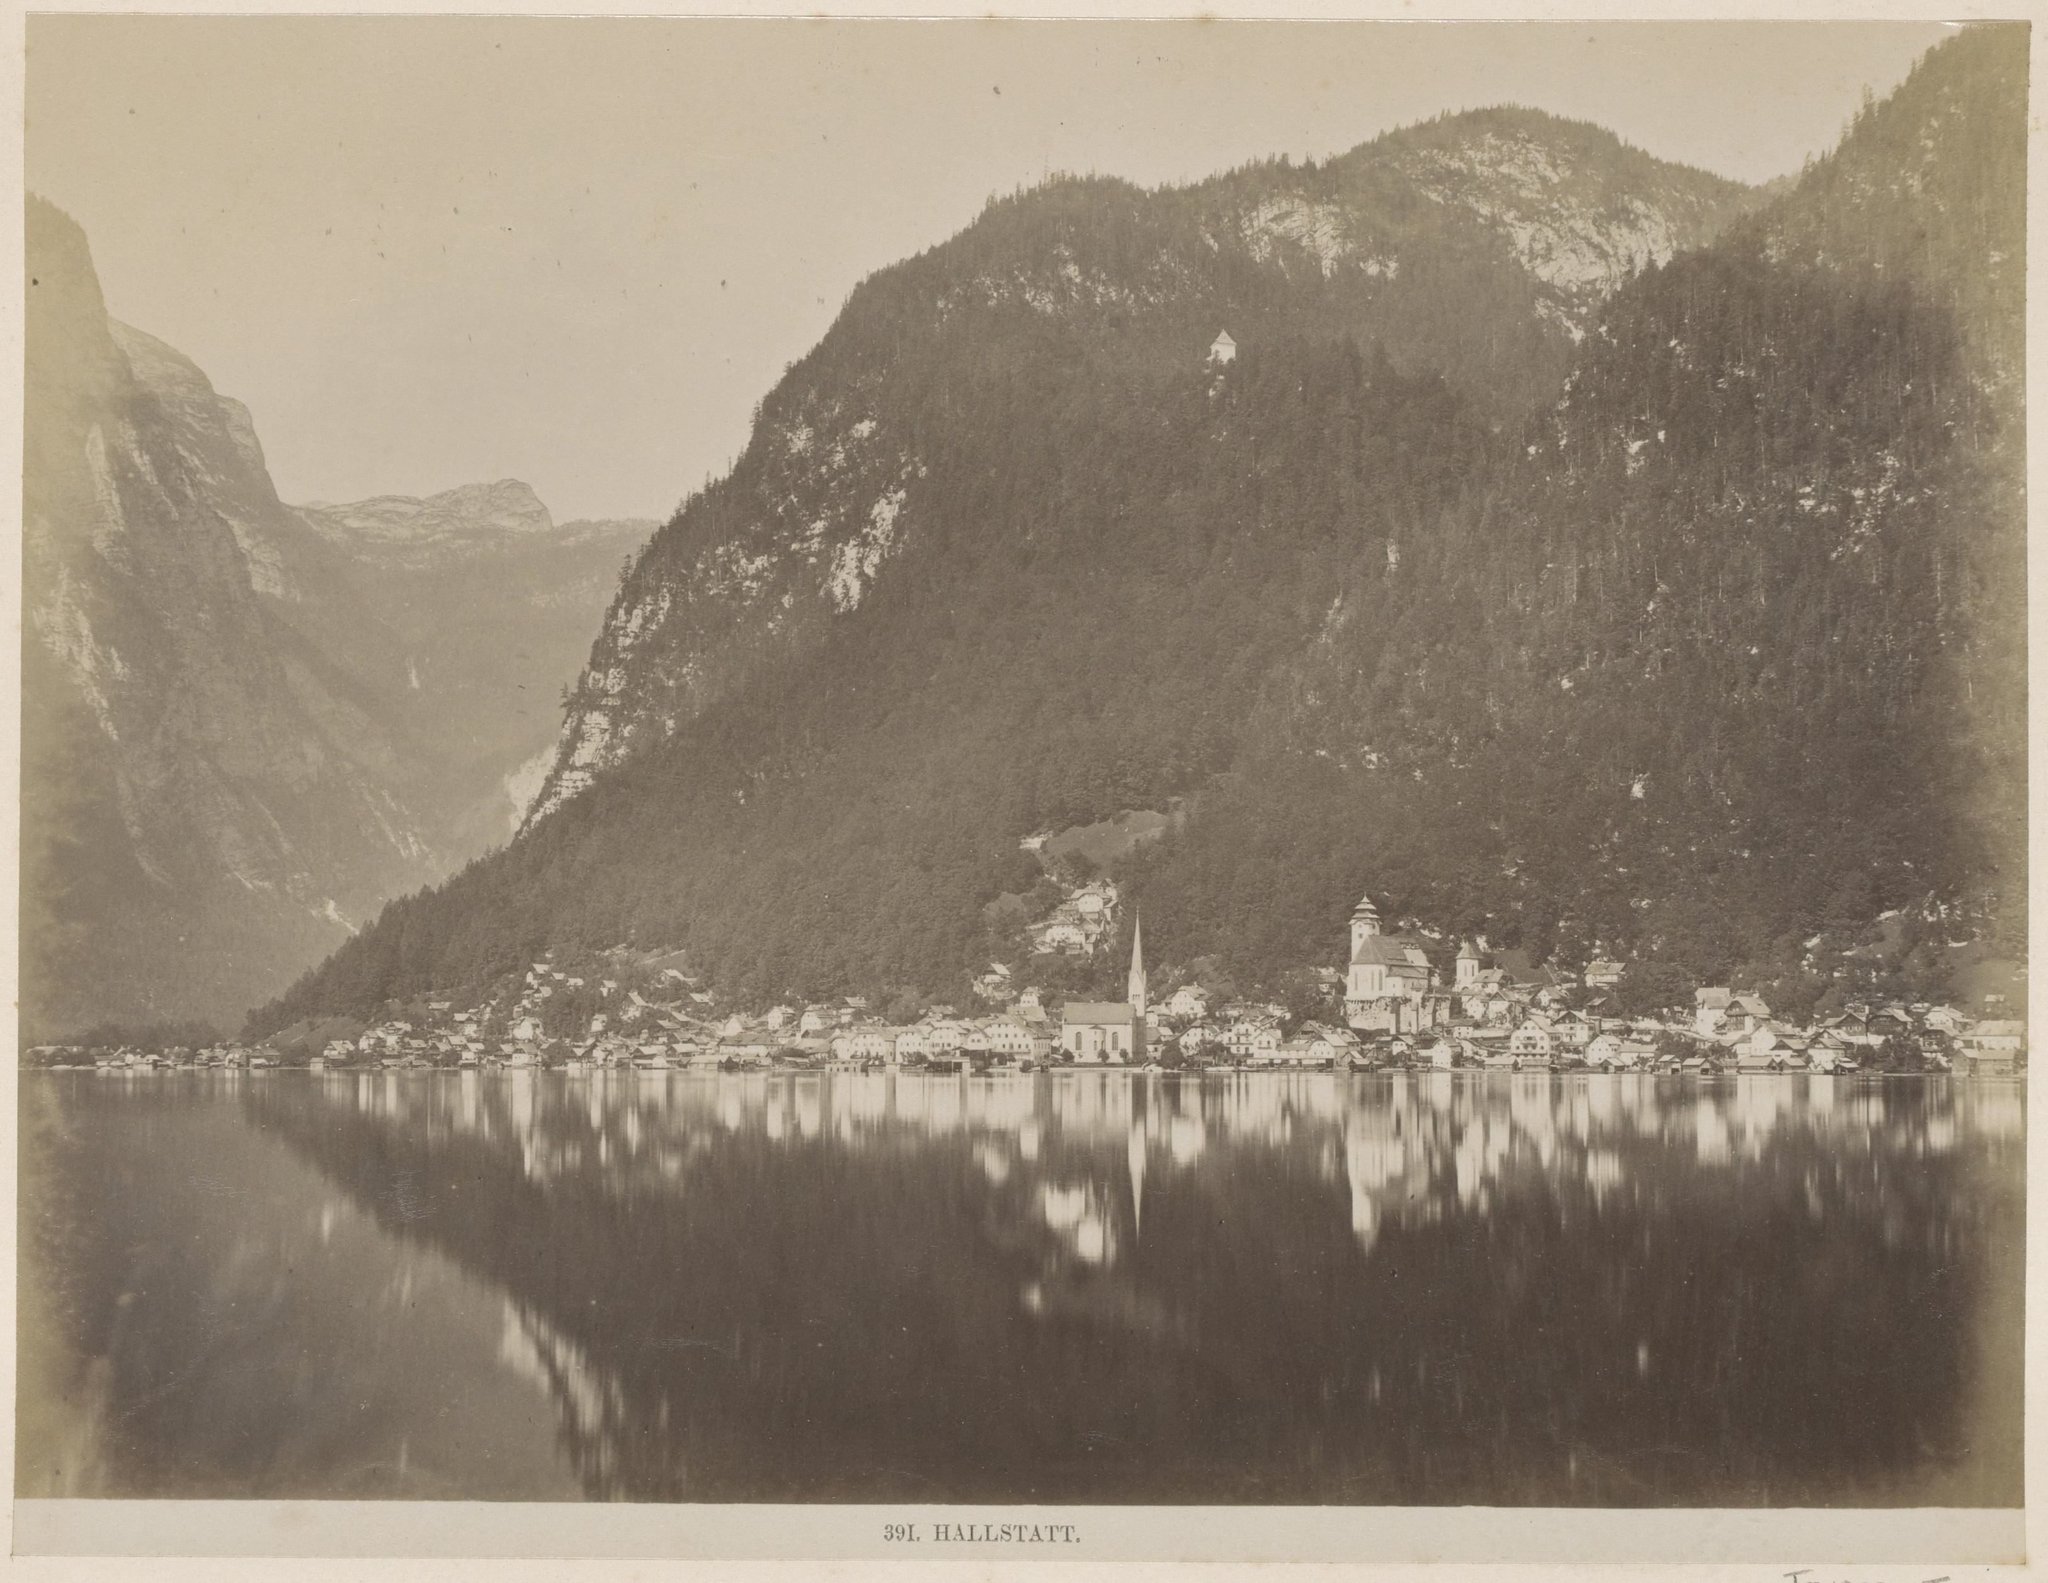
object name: photograph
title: Gezicht op Hallstatt met meer en omliggende bergen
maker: Anonymous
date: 1870-1900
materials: paper, photographic support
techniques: albumen print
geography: hallstatt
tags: prospect of village, silhouette of village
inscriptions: negative number: ‘391’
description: Onderdeel van Reisalbum met foto's van bezienswaardigheden in Duitsland en Oostenrijk en van kunstwerken.